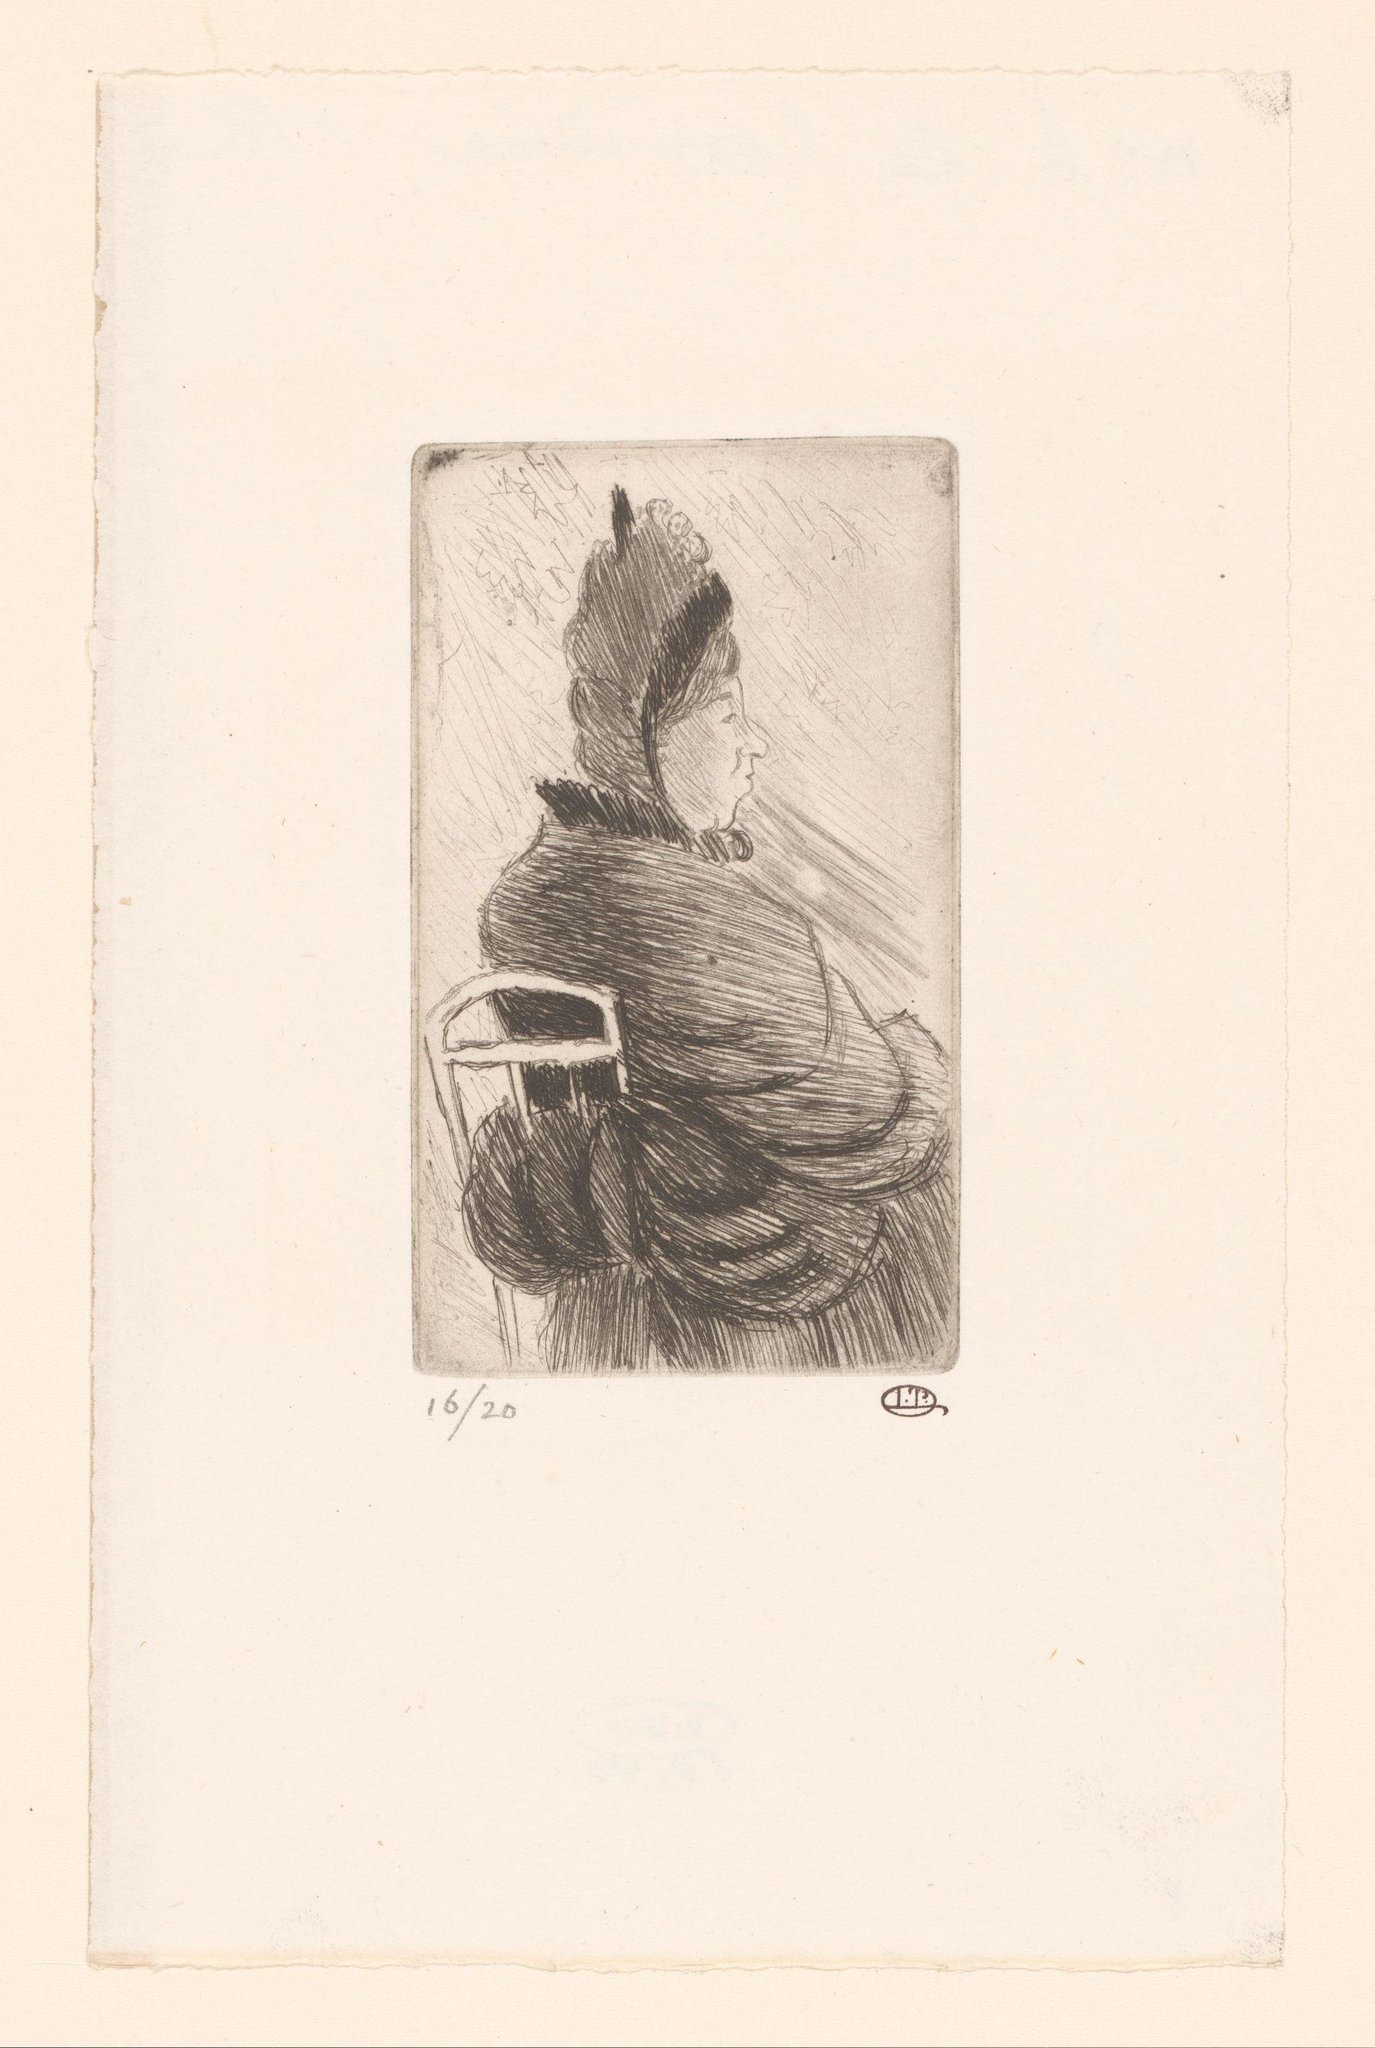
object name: print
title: Zittende vrouw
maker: lucien pissarro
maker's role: painter, print maker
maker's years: 1863-1944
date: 1873-1944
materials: paper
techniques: etching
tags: adult woman (+ sitting)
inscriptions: monogram: Lugt 1756b, collector's mark: Lugt 2228